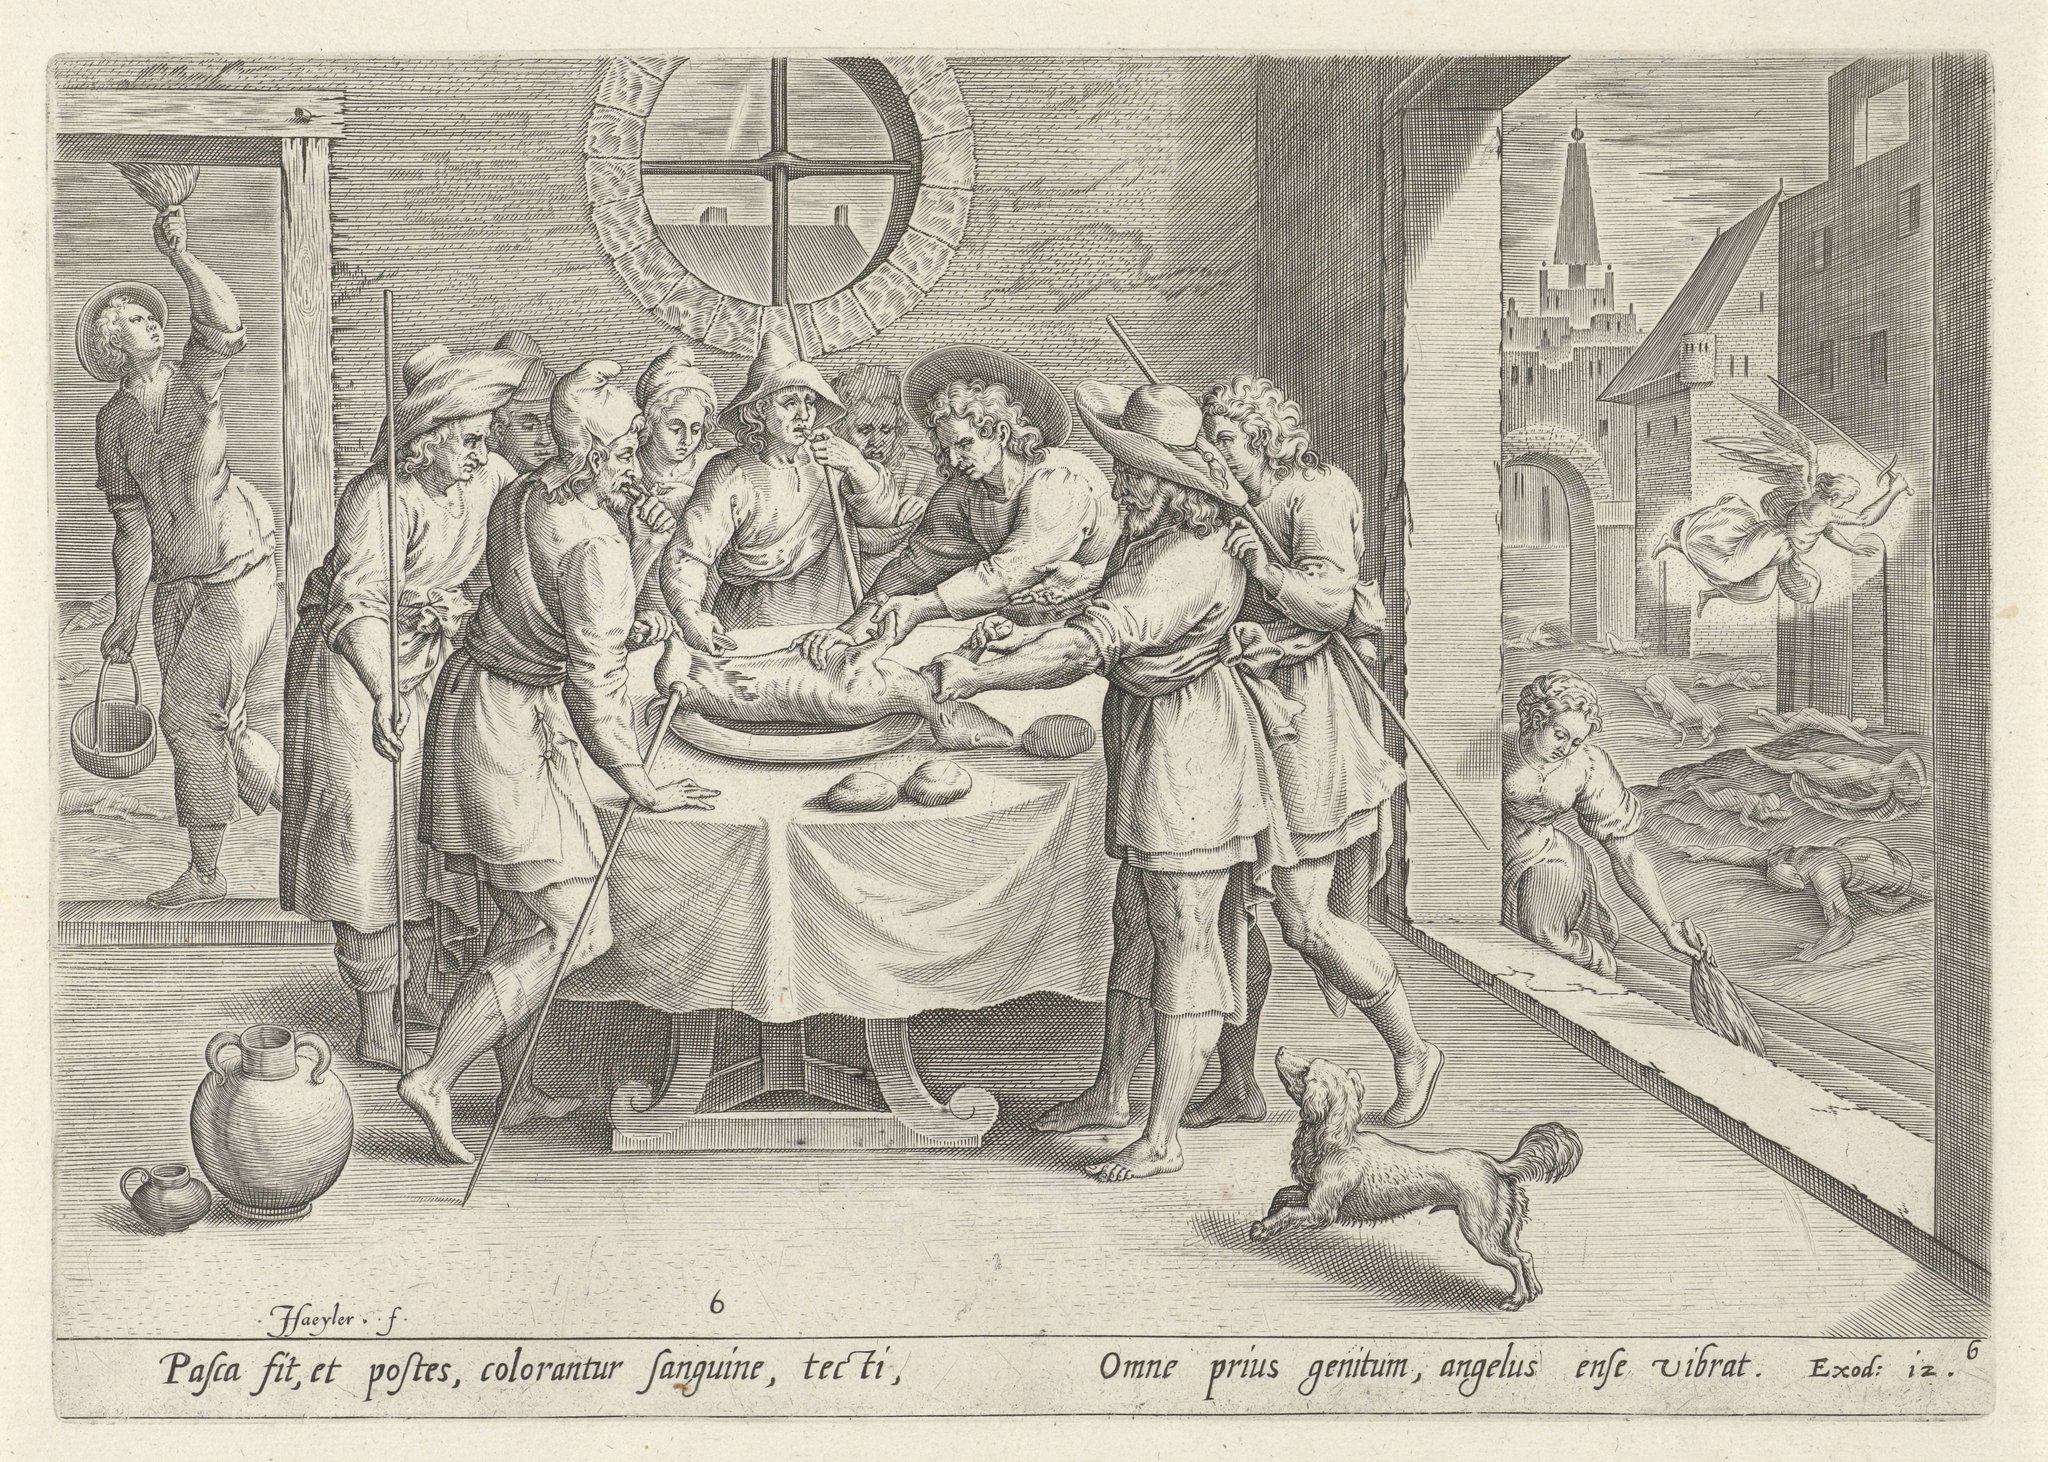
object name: print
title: Paasfeest en de tiende plaag van Egypte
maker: johann sadeler (i)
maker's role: print maker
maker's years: 1550-1600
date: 1579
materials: paper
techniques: engraving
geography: antwerp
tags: with lamb's blood the israelites make marks (usually tau-crosses) on the doorposts of their houses, the israelites eat the passover lamb standing about a table with their loins girt, their shoes on their feet and with staves in their hands, ready to depart, the plague of the first-born: the destroying angel passes through the land and kills every egyptian first-born of man and animal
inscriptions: collector's mark: Lugt 2228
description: Het interieur van een woning. Op de voorgrond een Joodse familie rond een tafel met het pesachoffer: een geslacht lam. Links worden de deuren van Joodse huizen met lamsbloed gemarkeerd. Rechts de tiende plaag van Egypte: een engel doodt alle eerstgeborenen van Egypte. De prent heeft een Latijns opschrift.